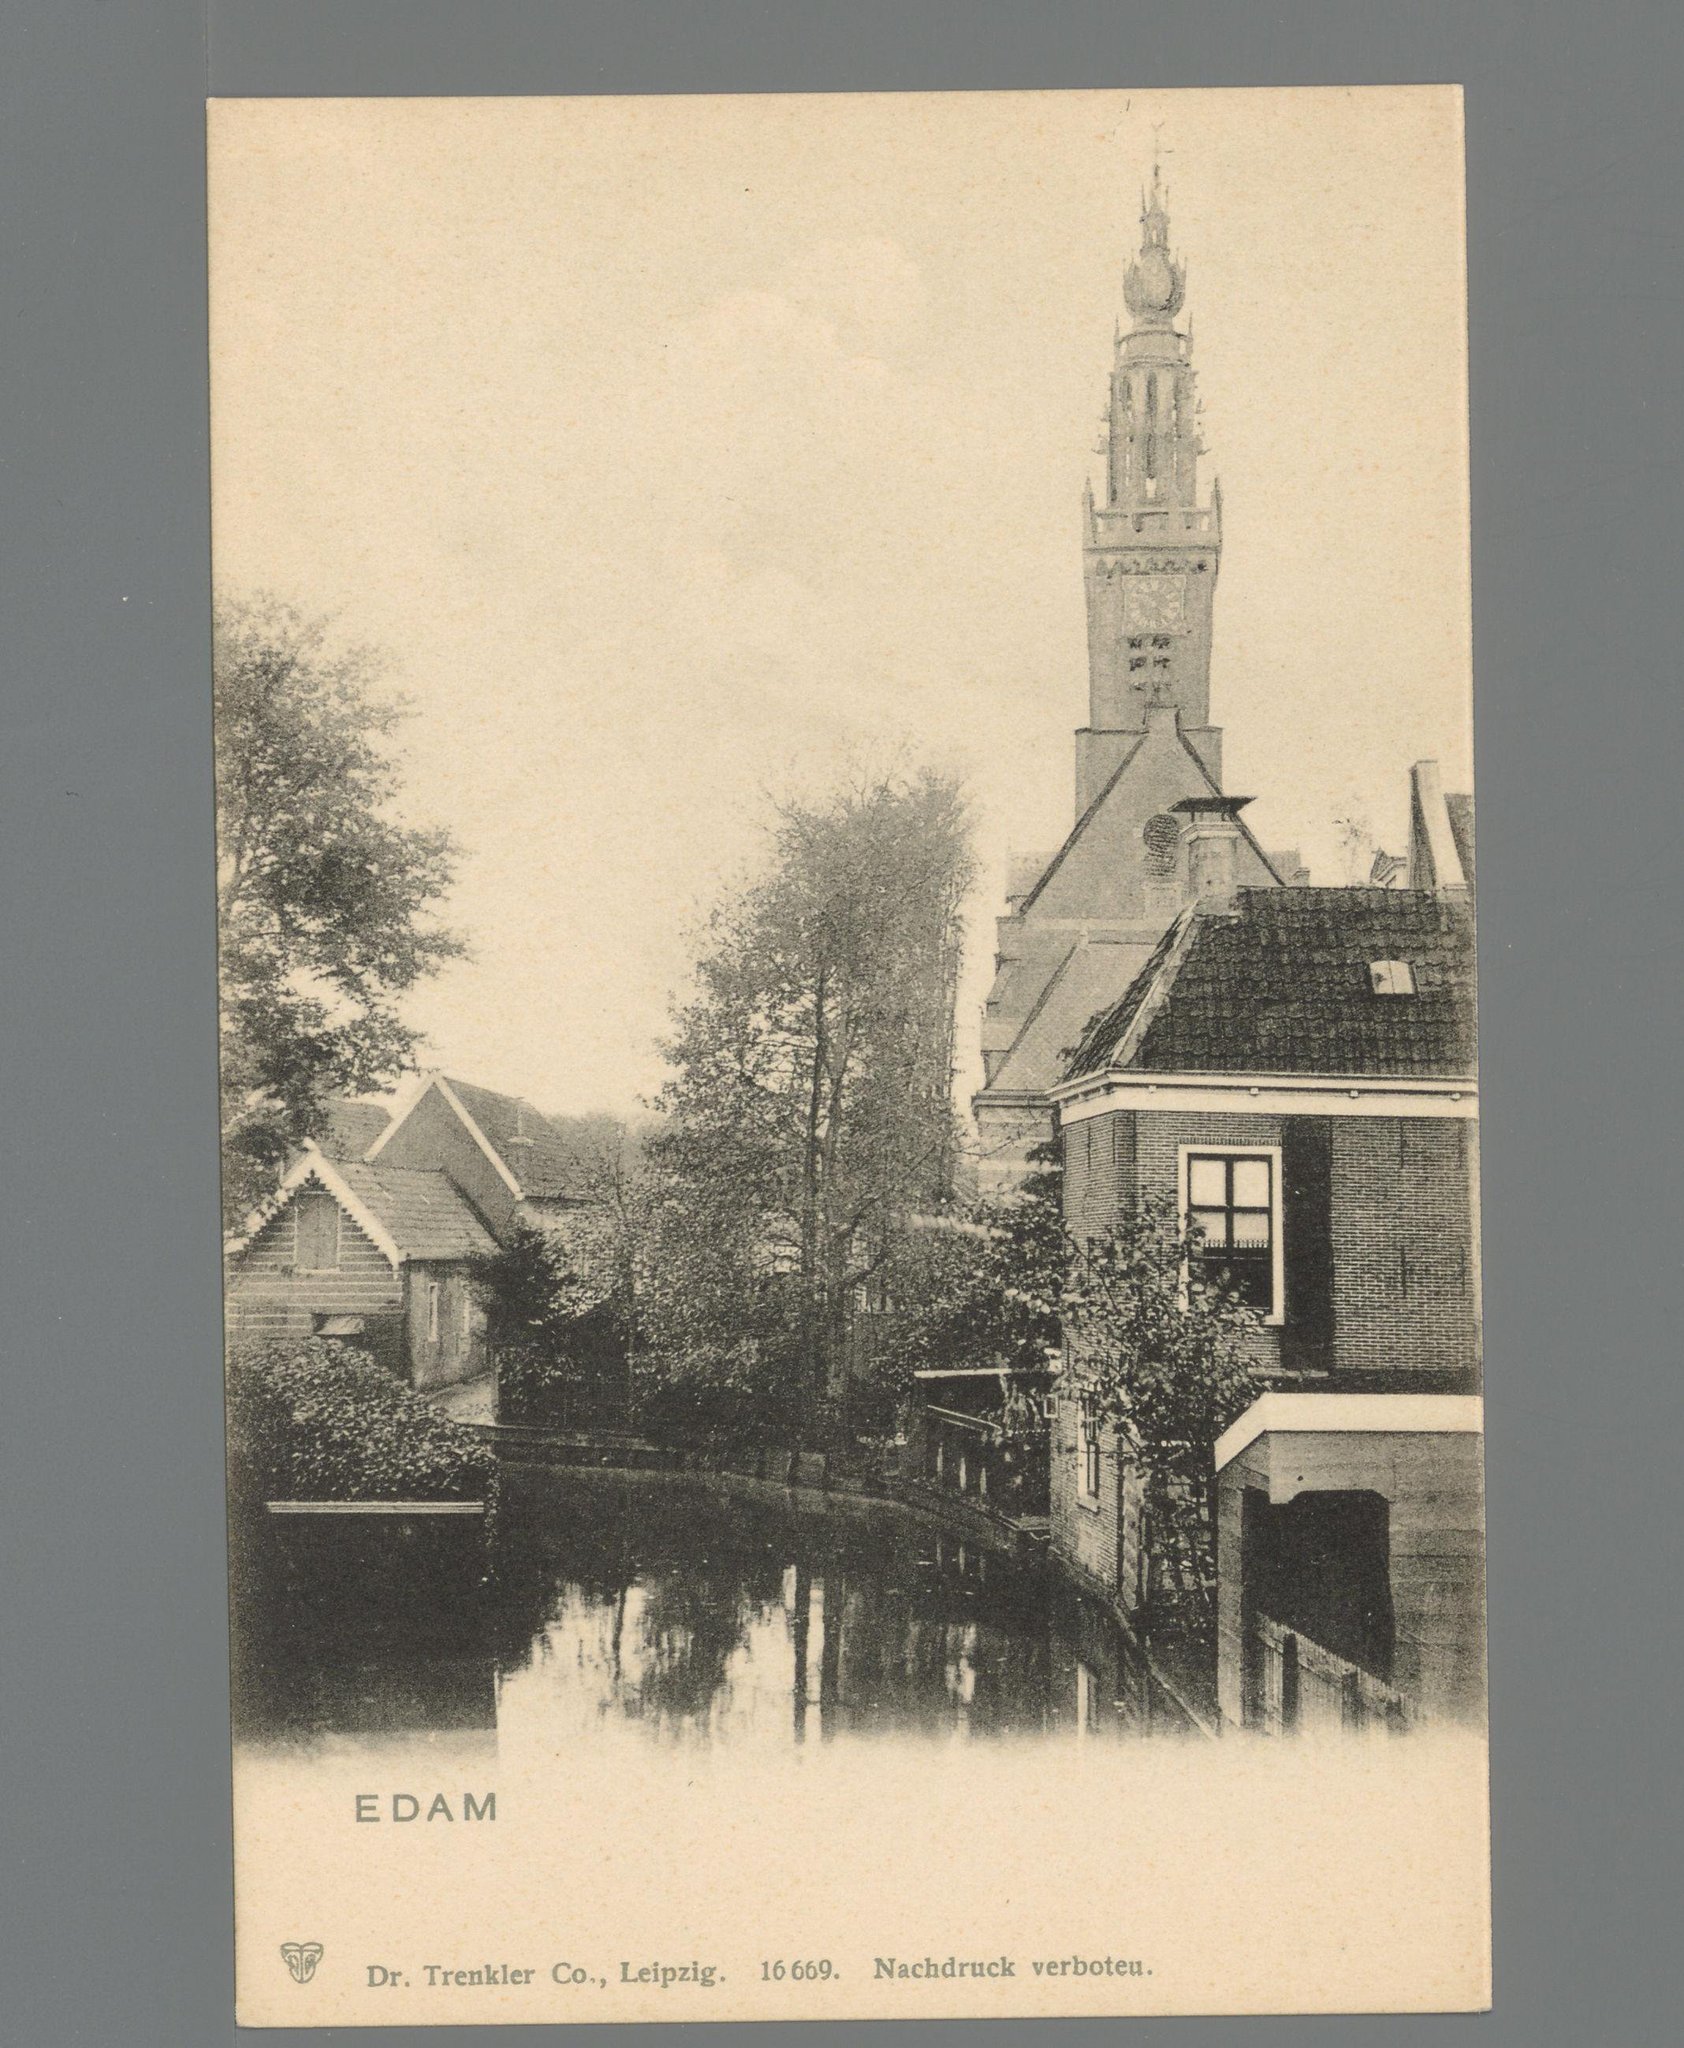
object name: ansichtkaart, prentbriefkaart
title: Edam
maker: Anonymous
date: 1892-1905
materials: cardboard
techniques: photograph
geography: edam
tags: city-view, and landscape with man-made constructions, church (exterior), canals, waters (in city)